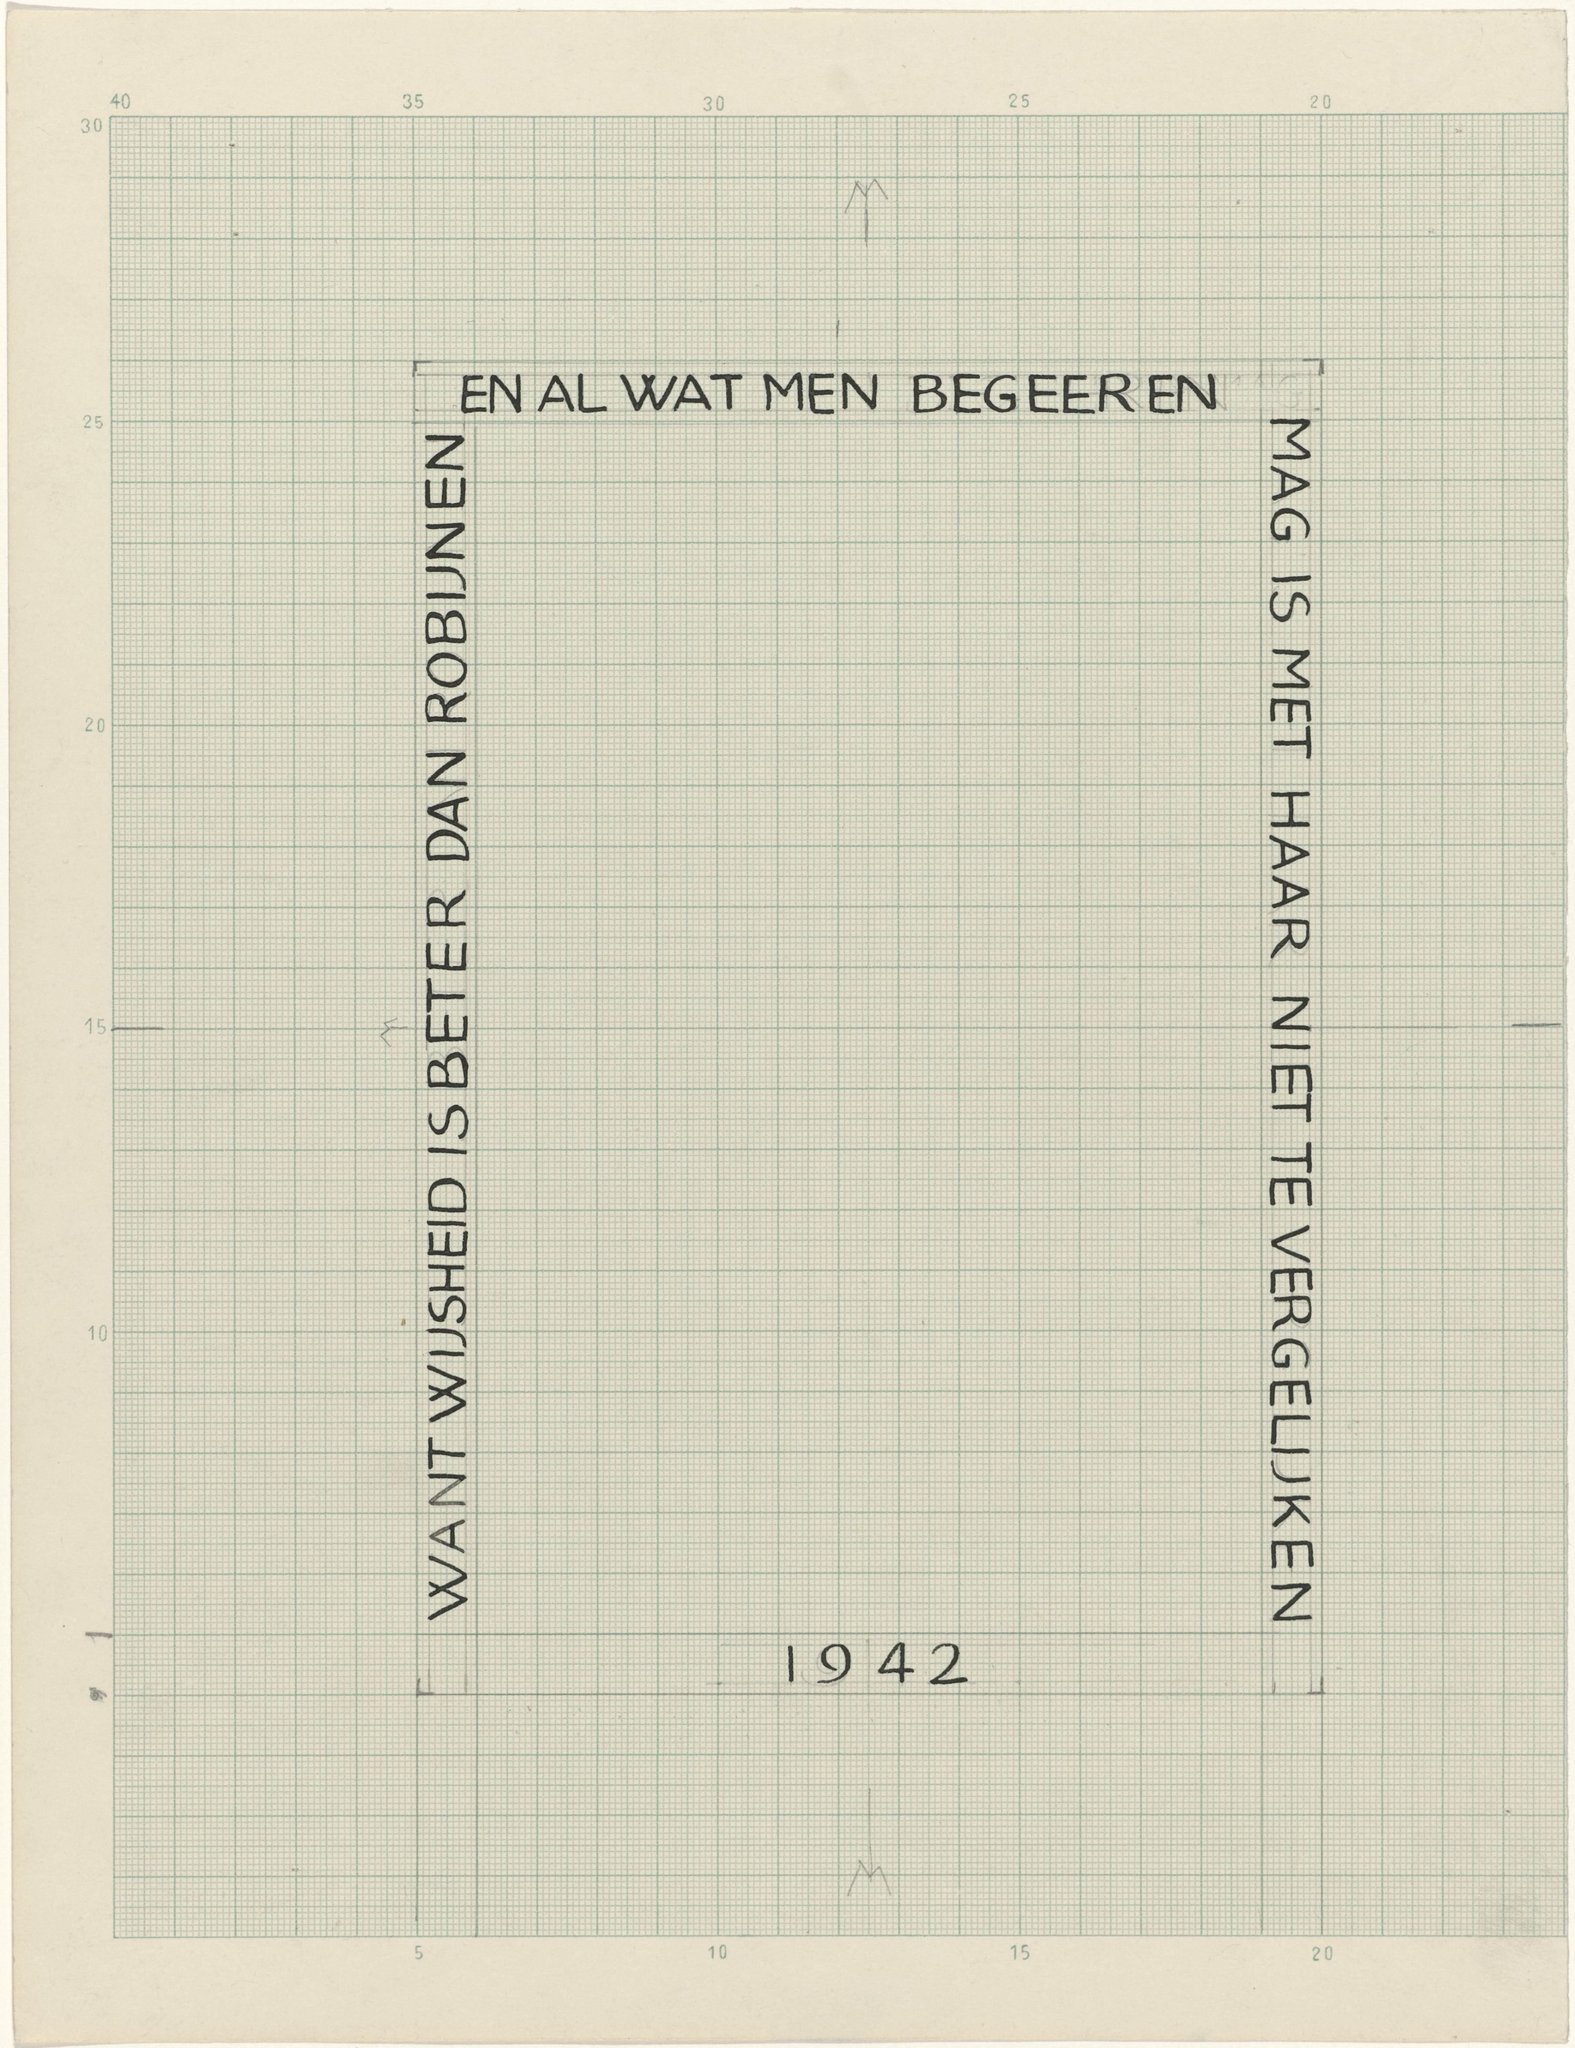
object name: design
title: Ontwerp met tekst in rand, voor een ex libris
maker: carel adolph lion cachet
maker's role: draughtsman, print maker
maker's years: 1864-1945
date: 1874-1945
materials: ink, pencil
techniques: pen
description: Mogelijk een ontwerp voor een ex-libris.